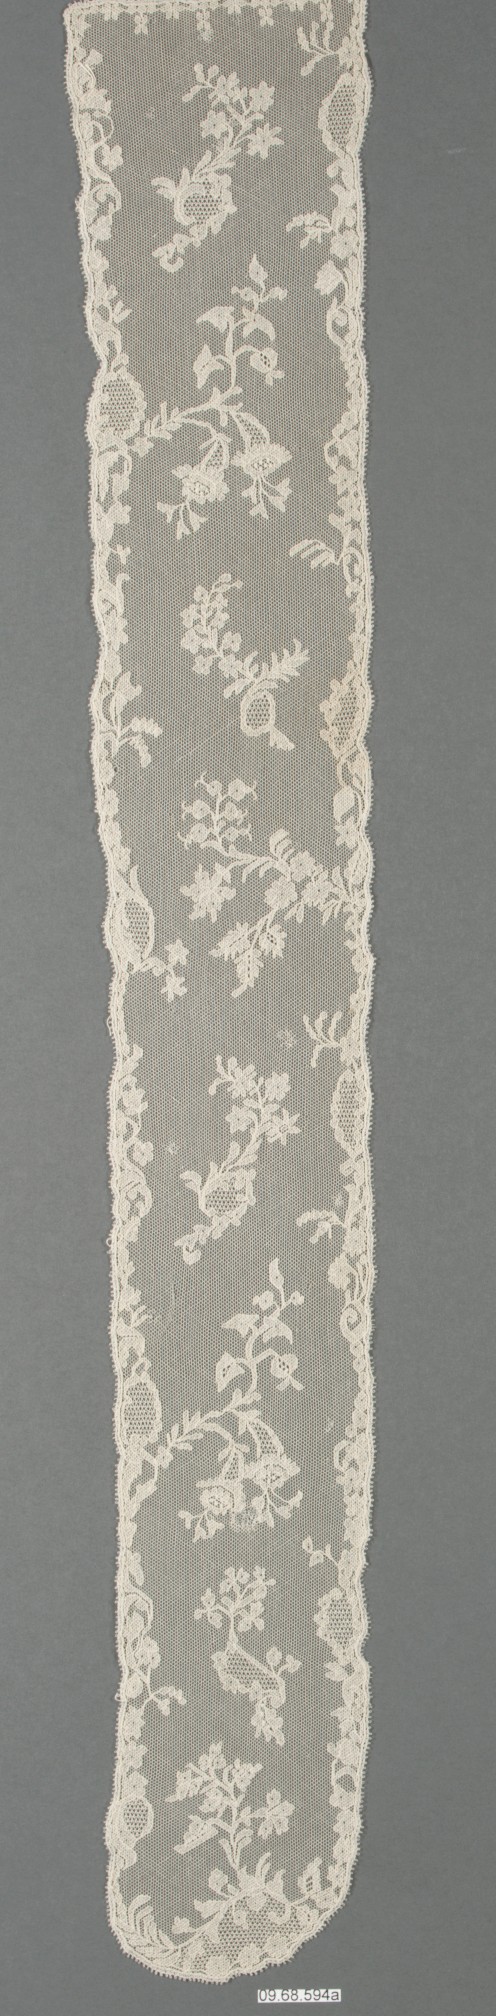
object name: lappet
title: Lappet (one of a pair)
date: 1801-1833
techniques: lace